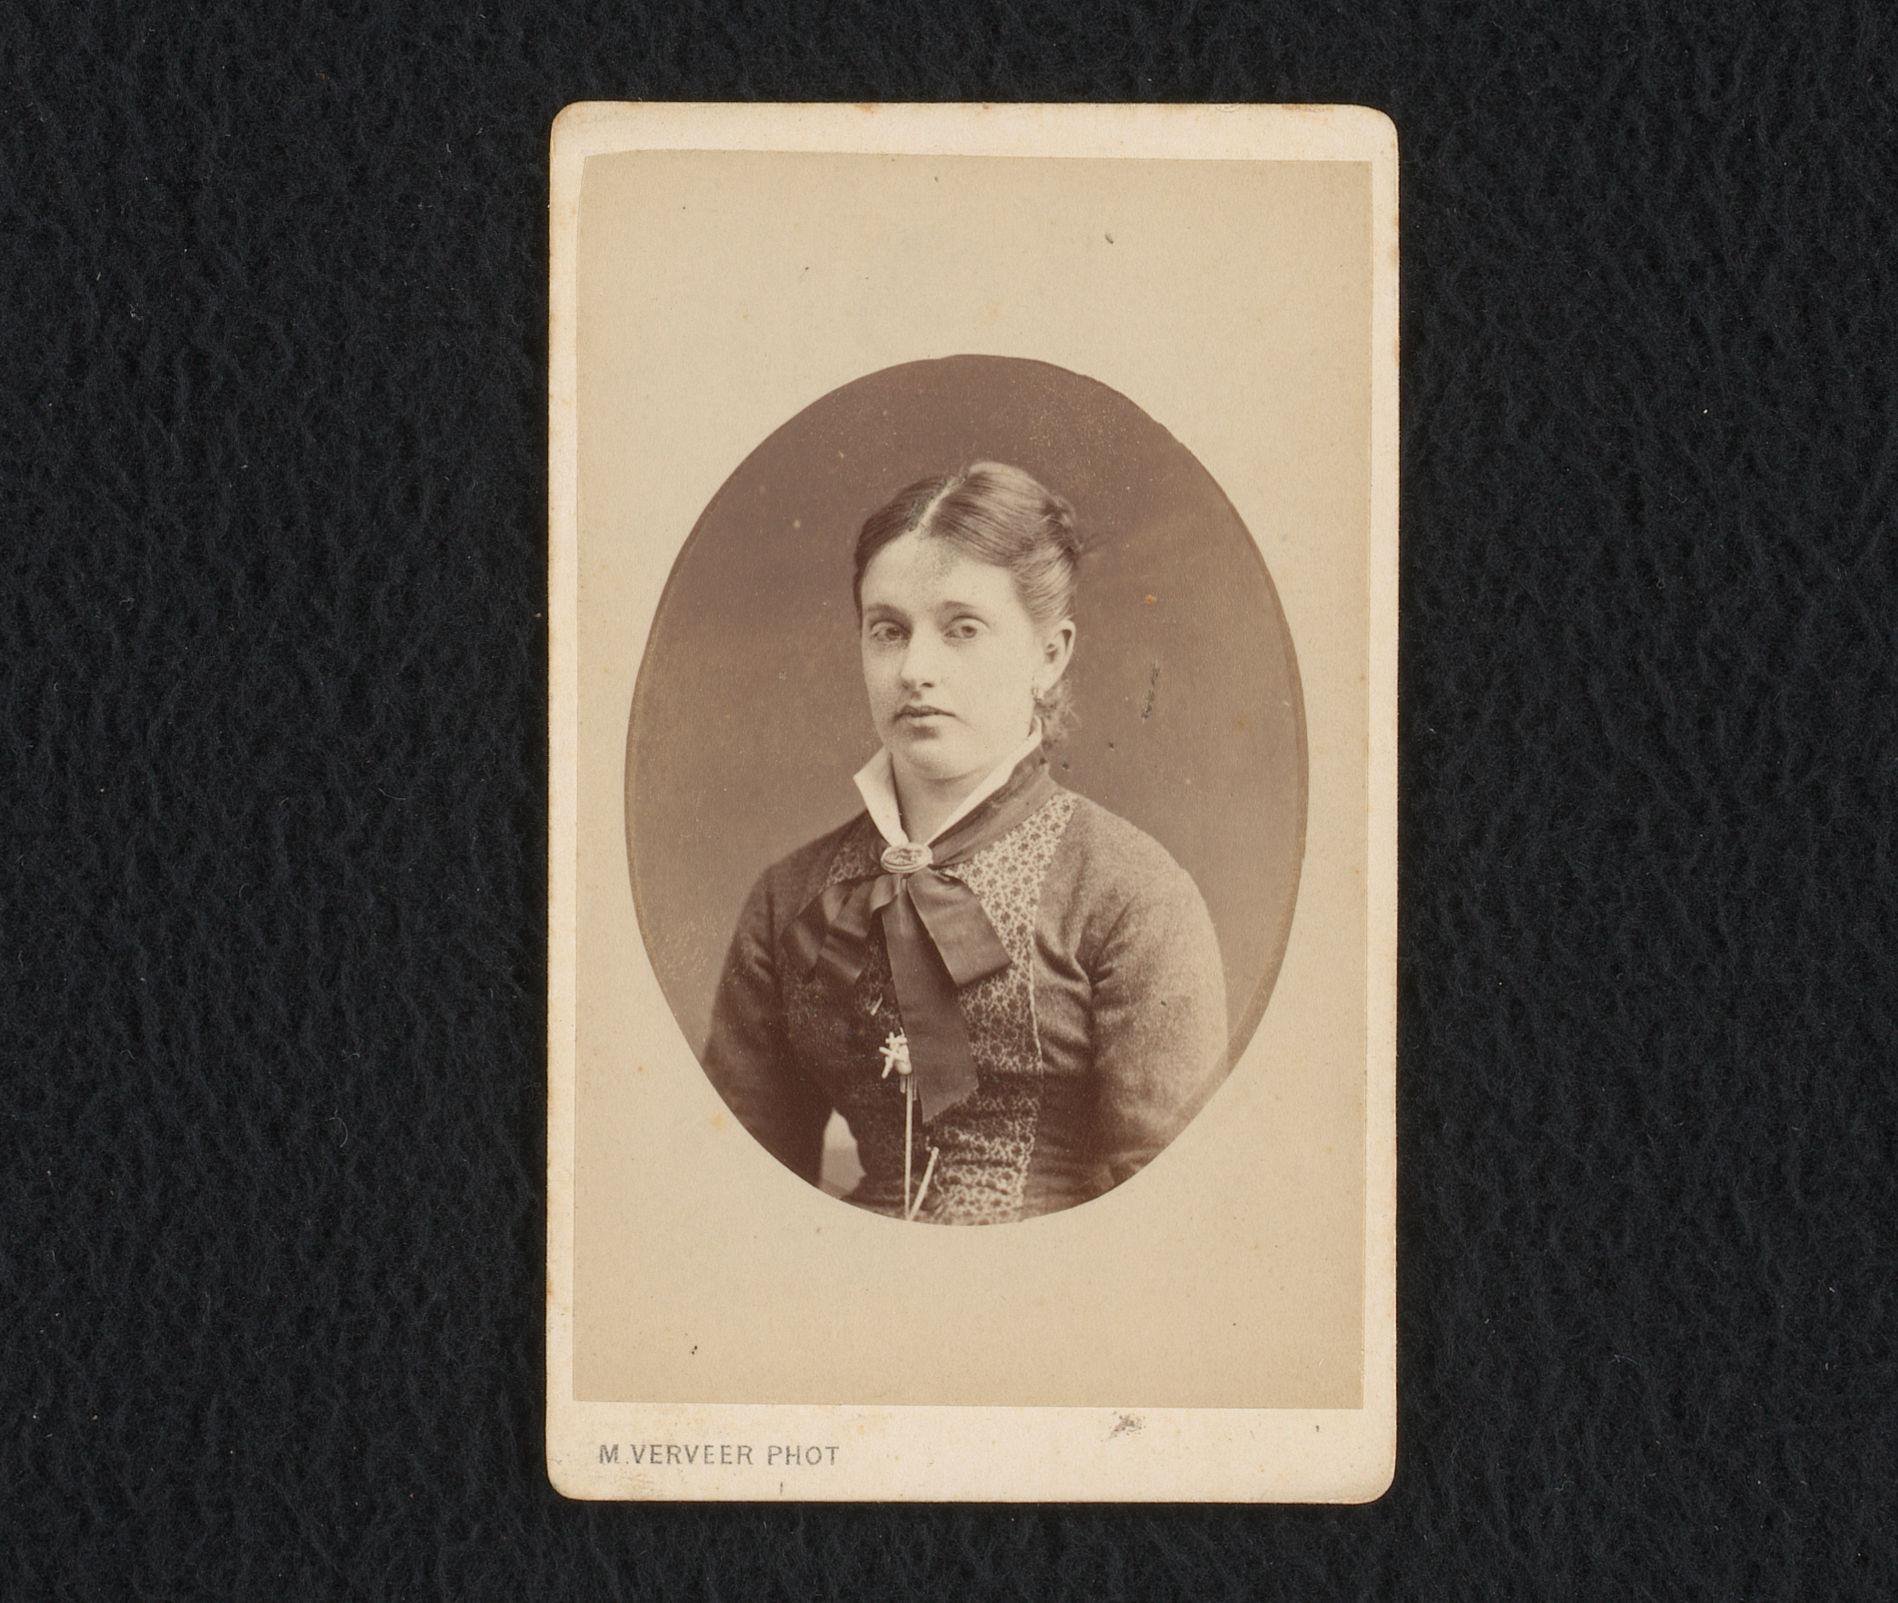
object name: carte de visite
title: Portret van een onbekende vrouw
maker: maurits verveer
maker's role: painter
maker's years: 1817-1903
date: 1864-1890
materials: cardboard, paper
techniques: albumen print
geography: the hague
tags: anonymous historical person portrayed - bb - woman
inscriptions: address: ‘52. Zeestraat, vis à vis/ du Willemspark la Haye.’, inscription: ‘Voor Margo’